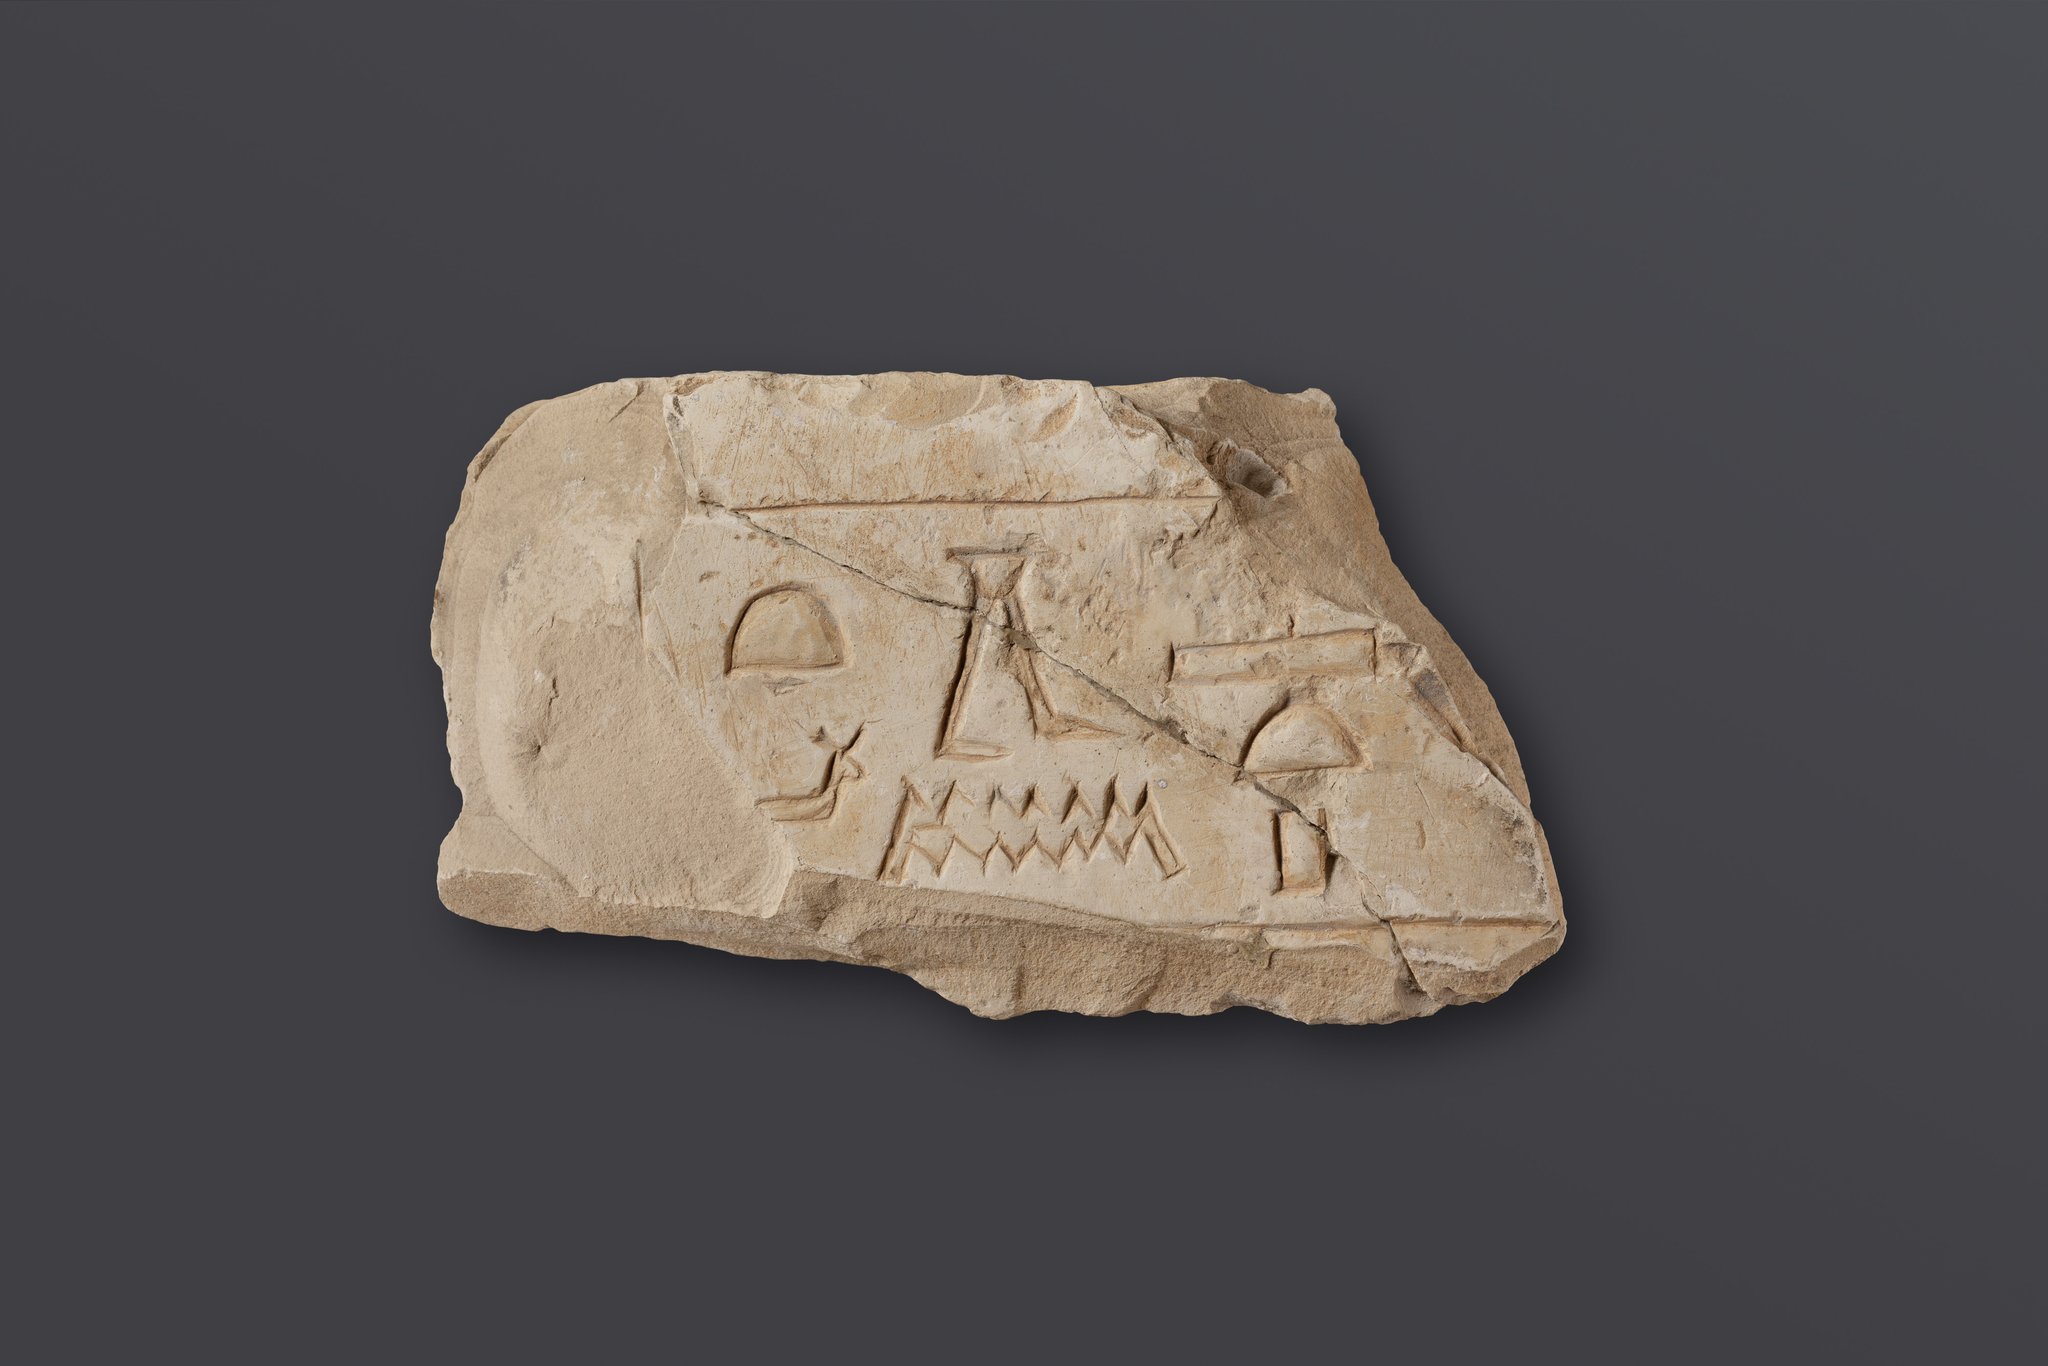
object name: relief fragment, intef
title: Relief fragment, Intef inscription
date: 2100-2090 BCE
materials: limestone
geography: egypt